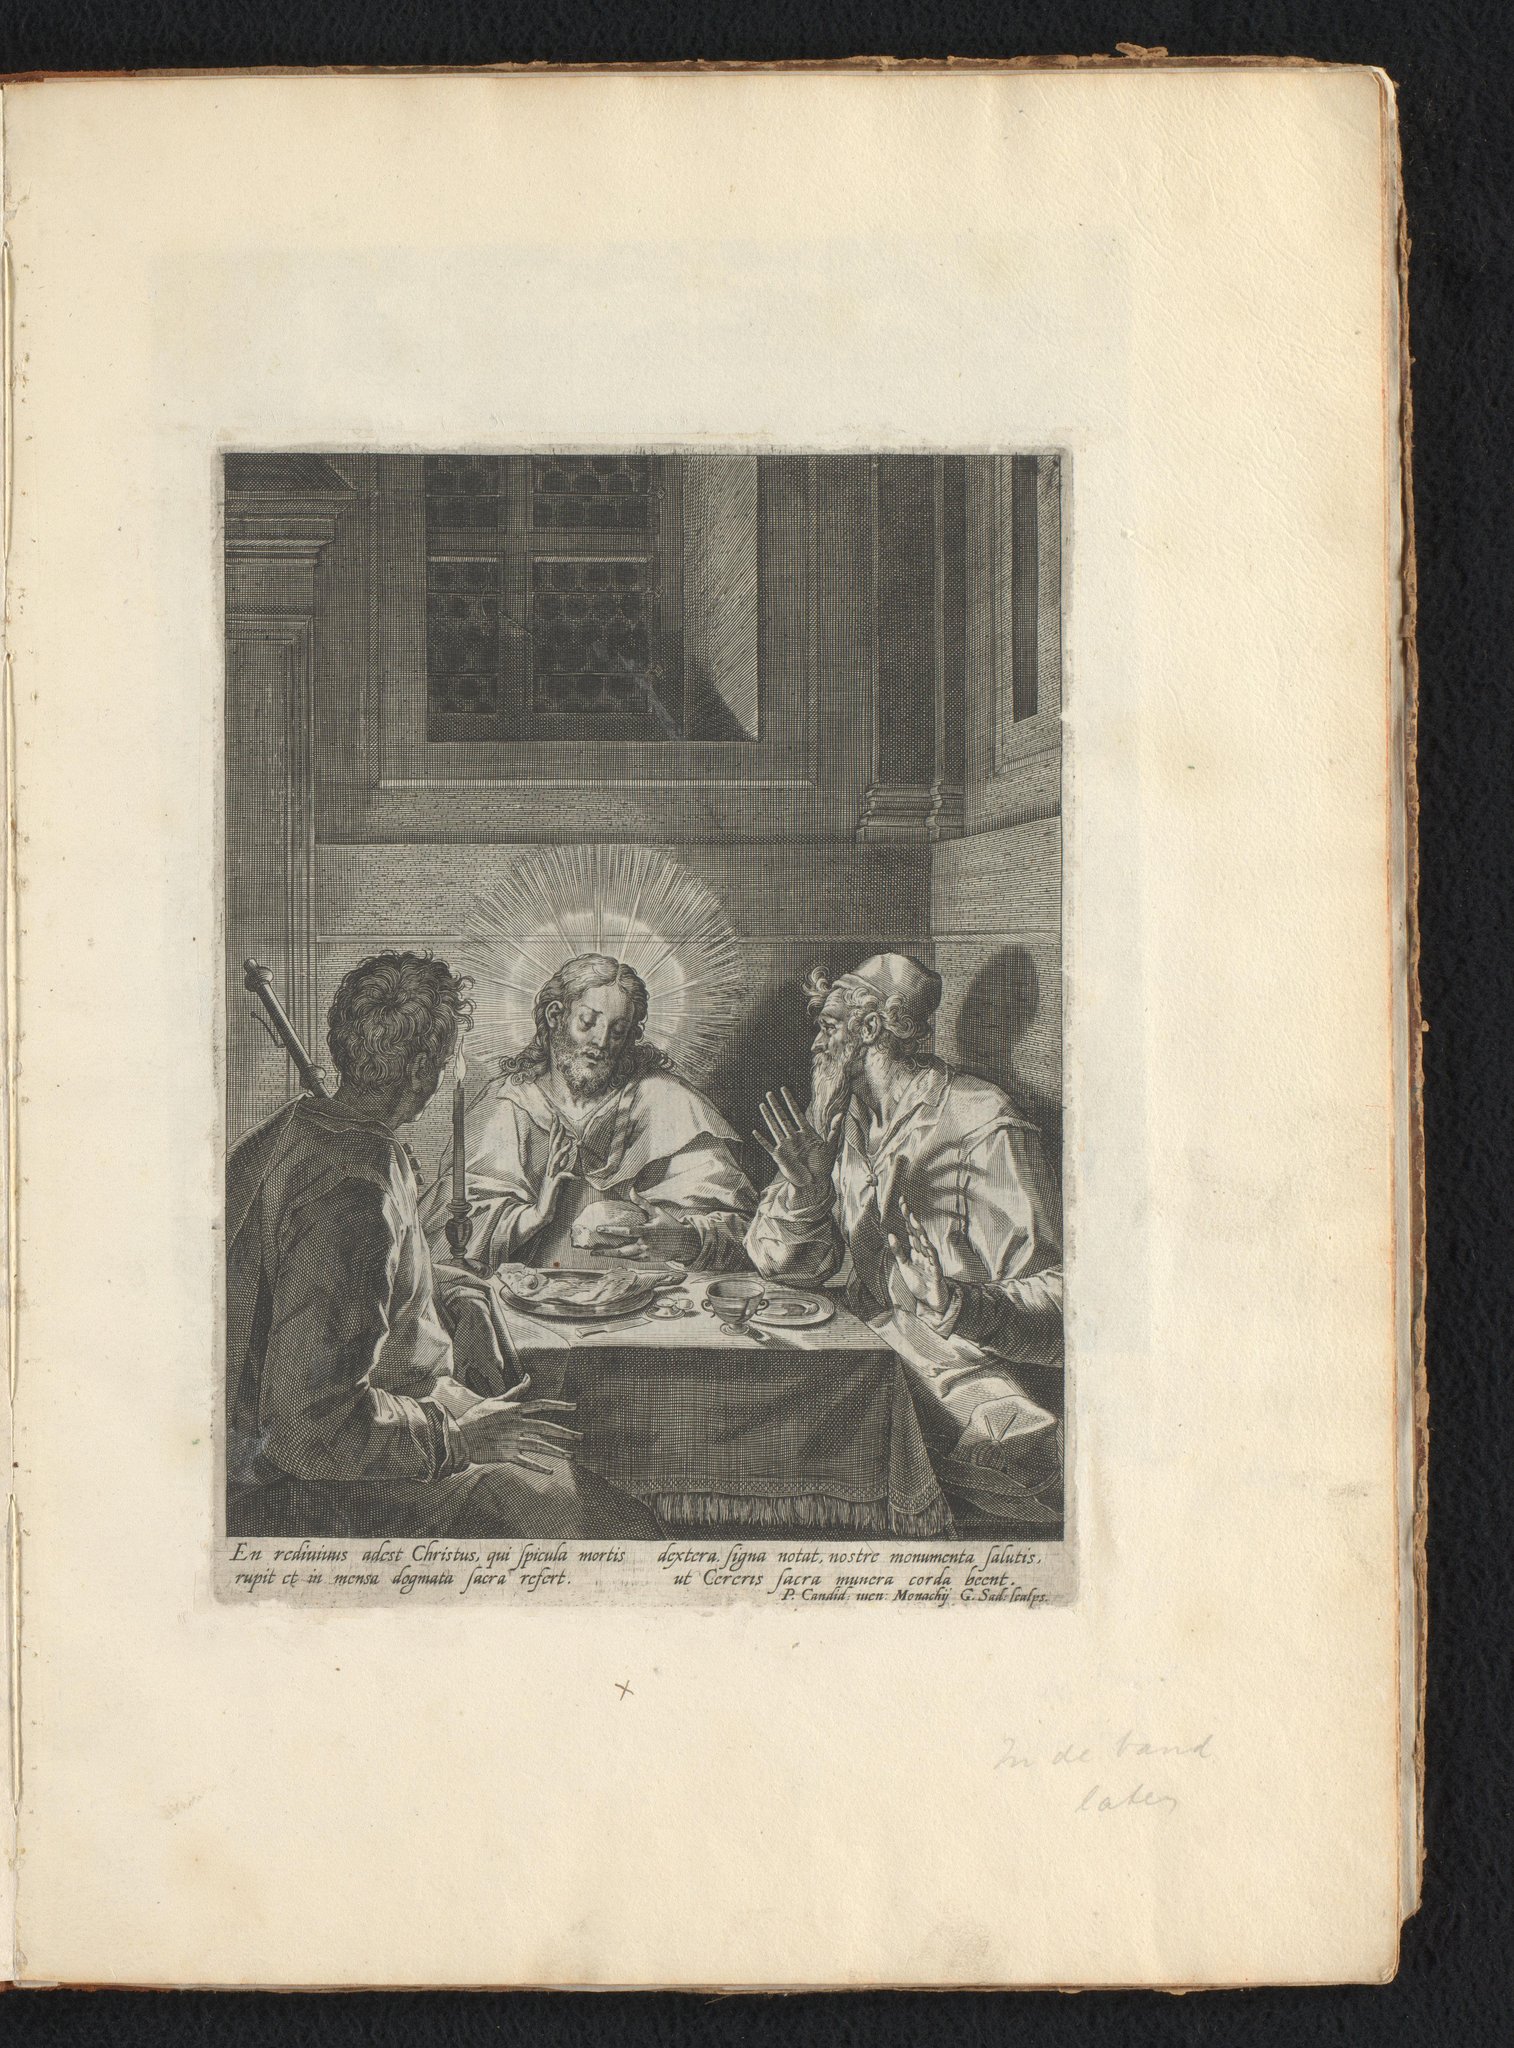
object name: print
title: Maaltijd in Emmaüs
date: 1580-1629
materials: paper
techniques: engraving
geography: munich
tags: the supper at emmaus: christ is recognized while blessing or breaking the bread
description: Christus met de twee Emmaüsgangers aan tafel in het dorp Emmaüs. Christus zit in het midden en zegent het brood. De leerlingen herkennen hem op dat moment. Onder de voorstelling een tekst in het Latijn. Deze prent maakt deel uit van een album.